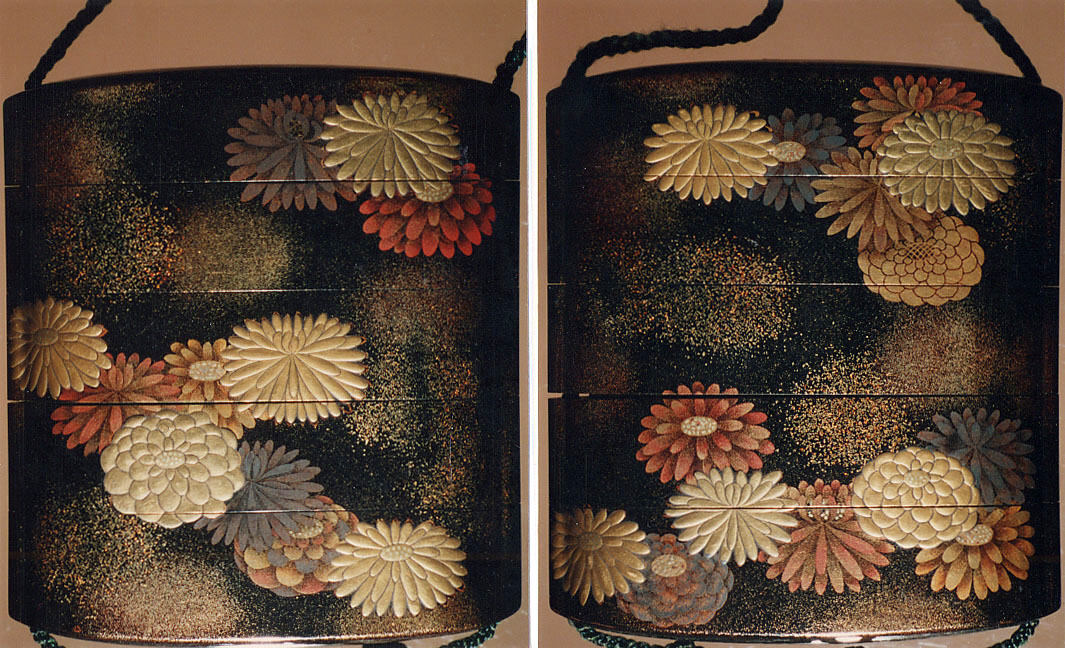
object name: inrō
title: Inrō with Scattered Chrysanthemums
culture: japanese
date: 1801-1850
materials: gold, ivory, lacquer, metal, silver, wood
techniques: hiramakie, lacquer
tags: flowers